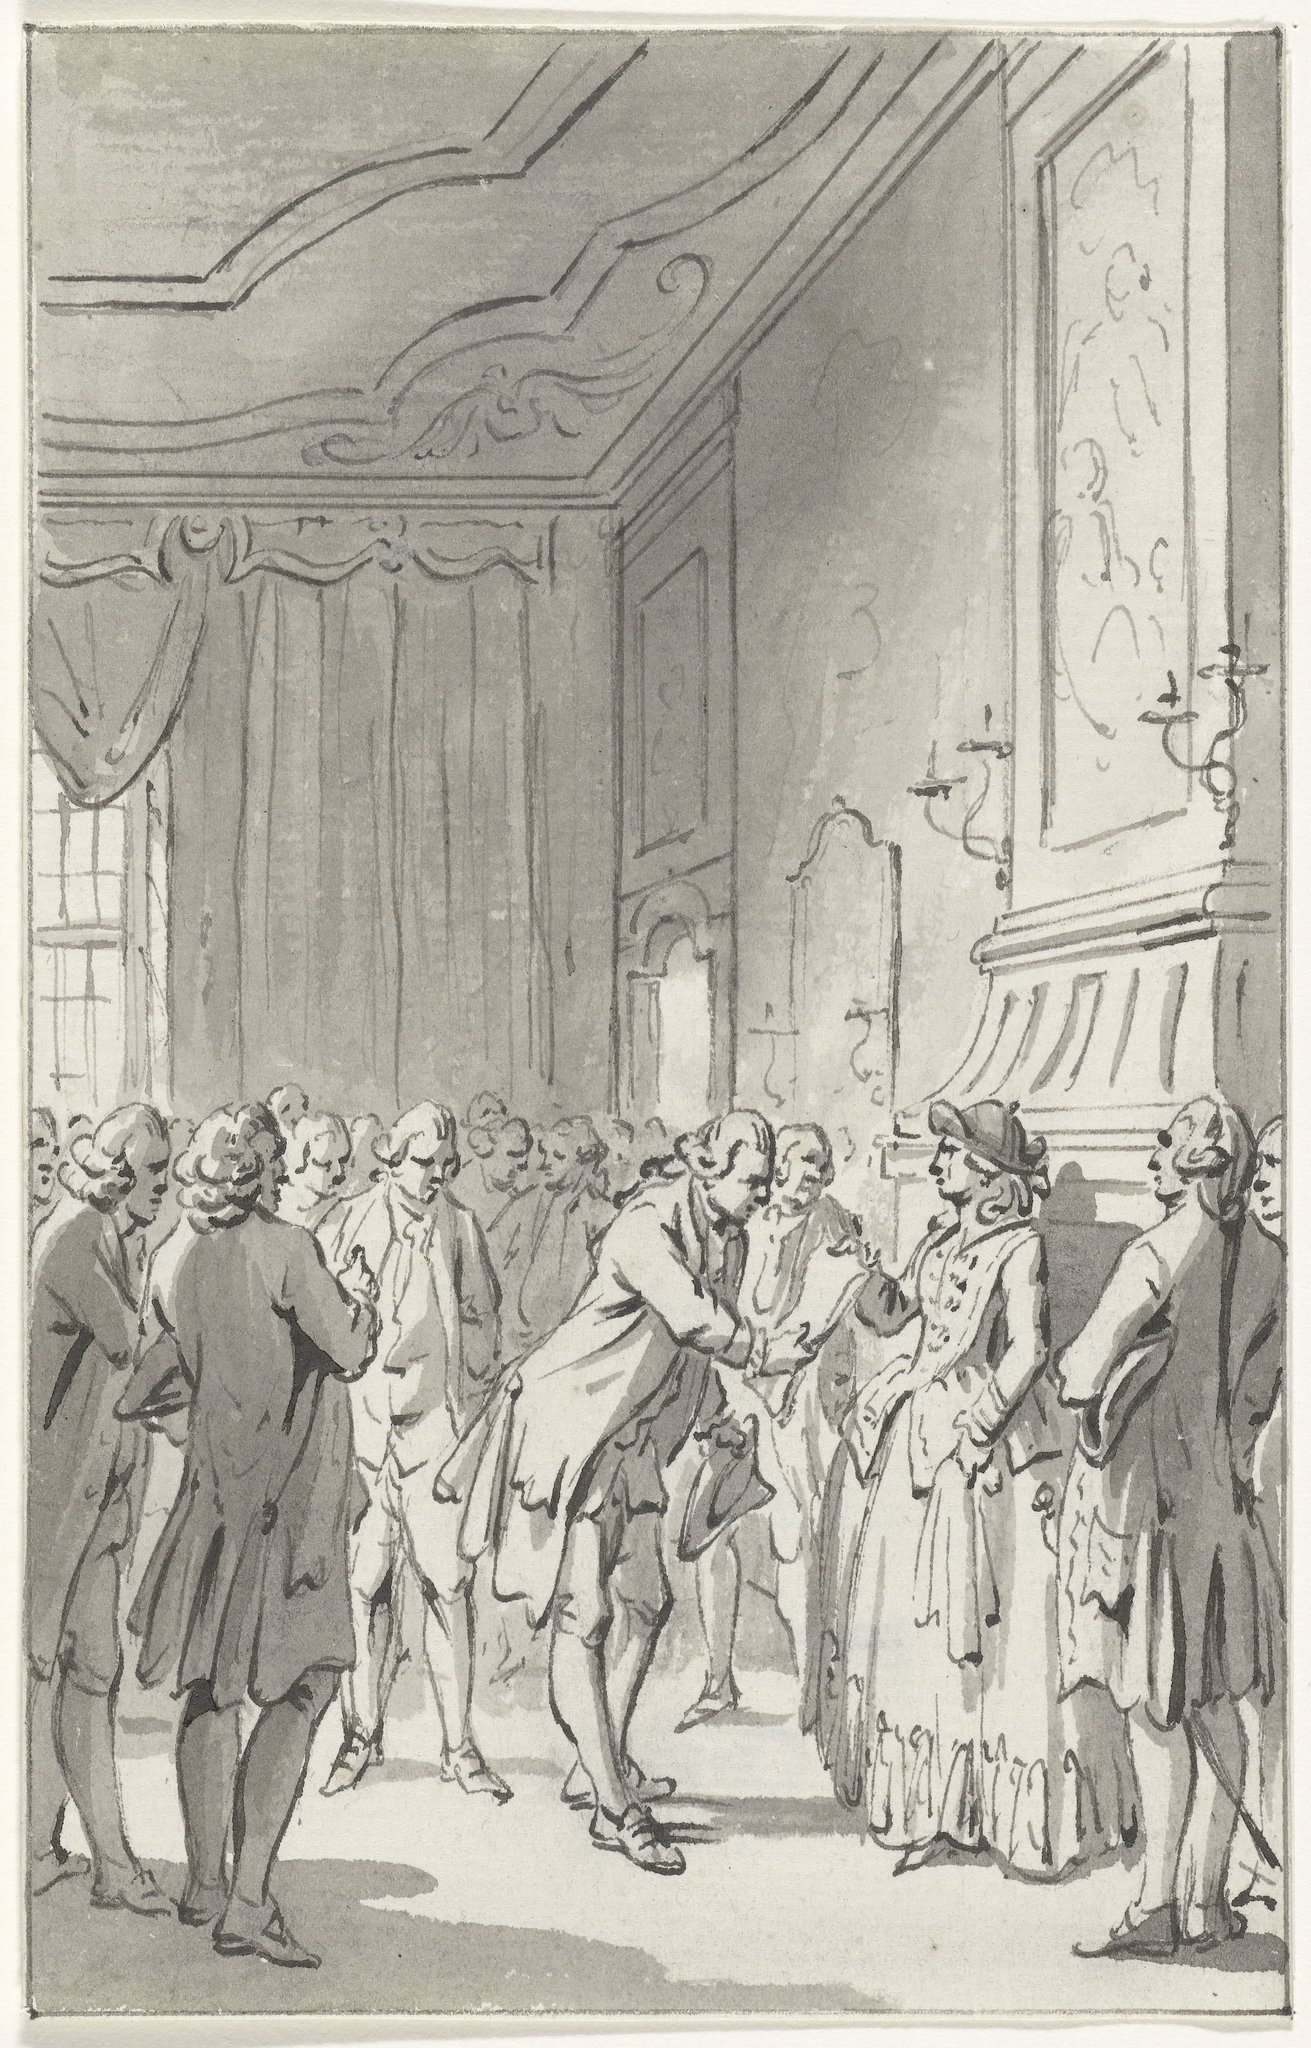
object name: drawing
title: Hollandse kooplieden bieden een klaagschrift aan aan Anna van Hannover, prinses van Oranje-Nassau, 7 december 1758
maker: jacobus buys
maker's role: draughtsman, print maker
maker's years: 1724-1801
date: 1758-1801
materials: ink, paper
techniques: brush, pen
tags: the hague, anna van hannover, historical persons, historical events and situations